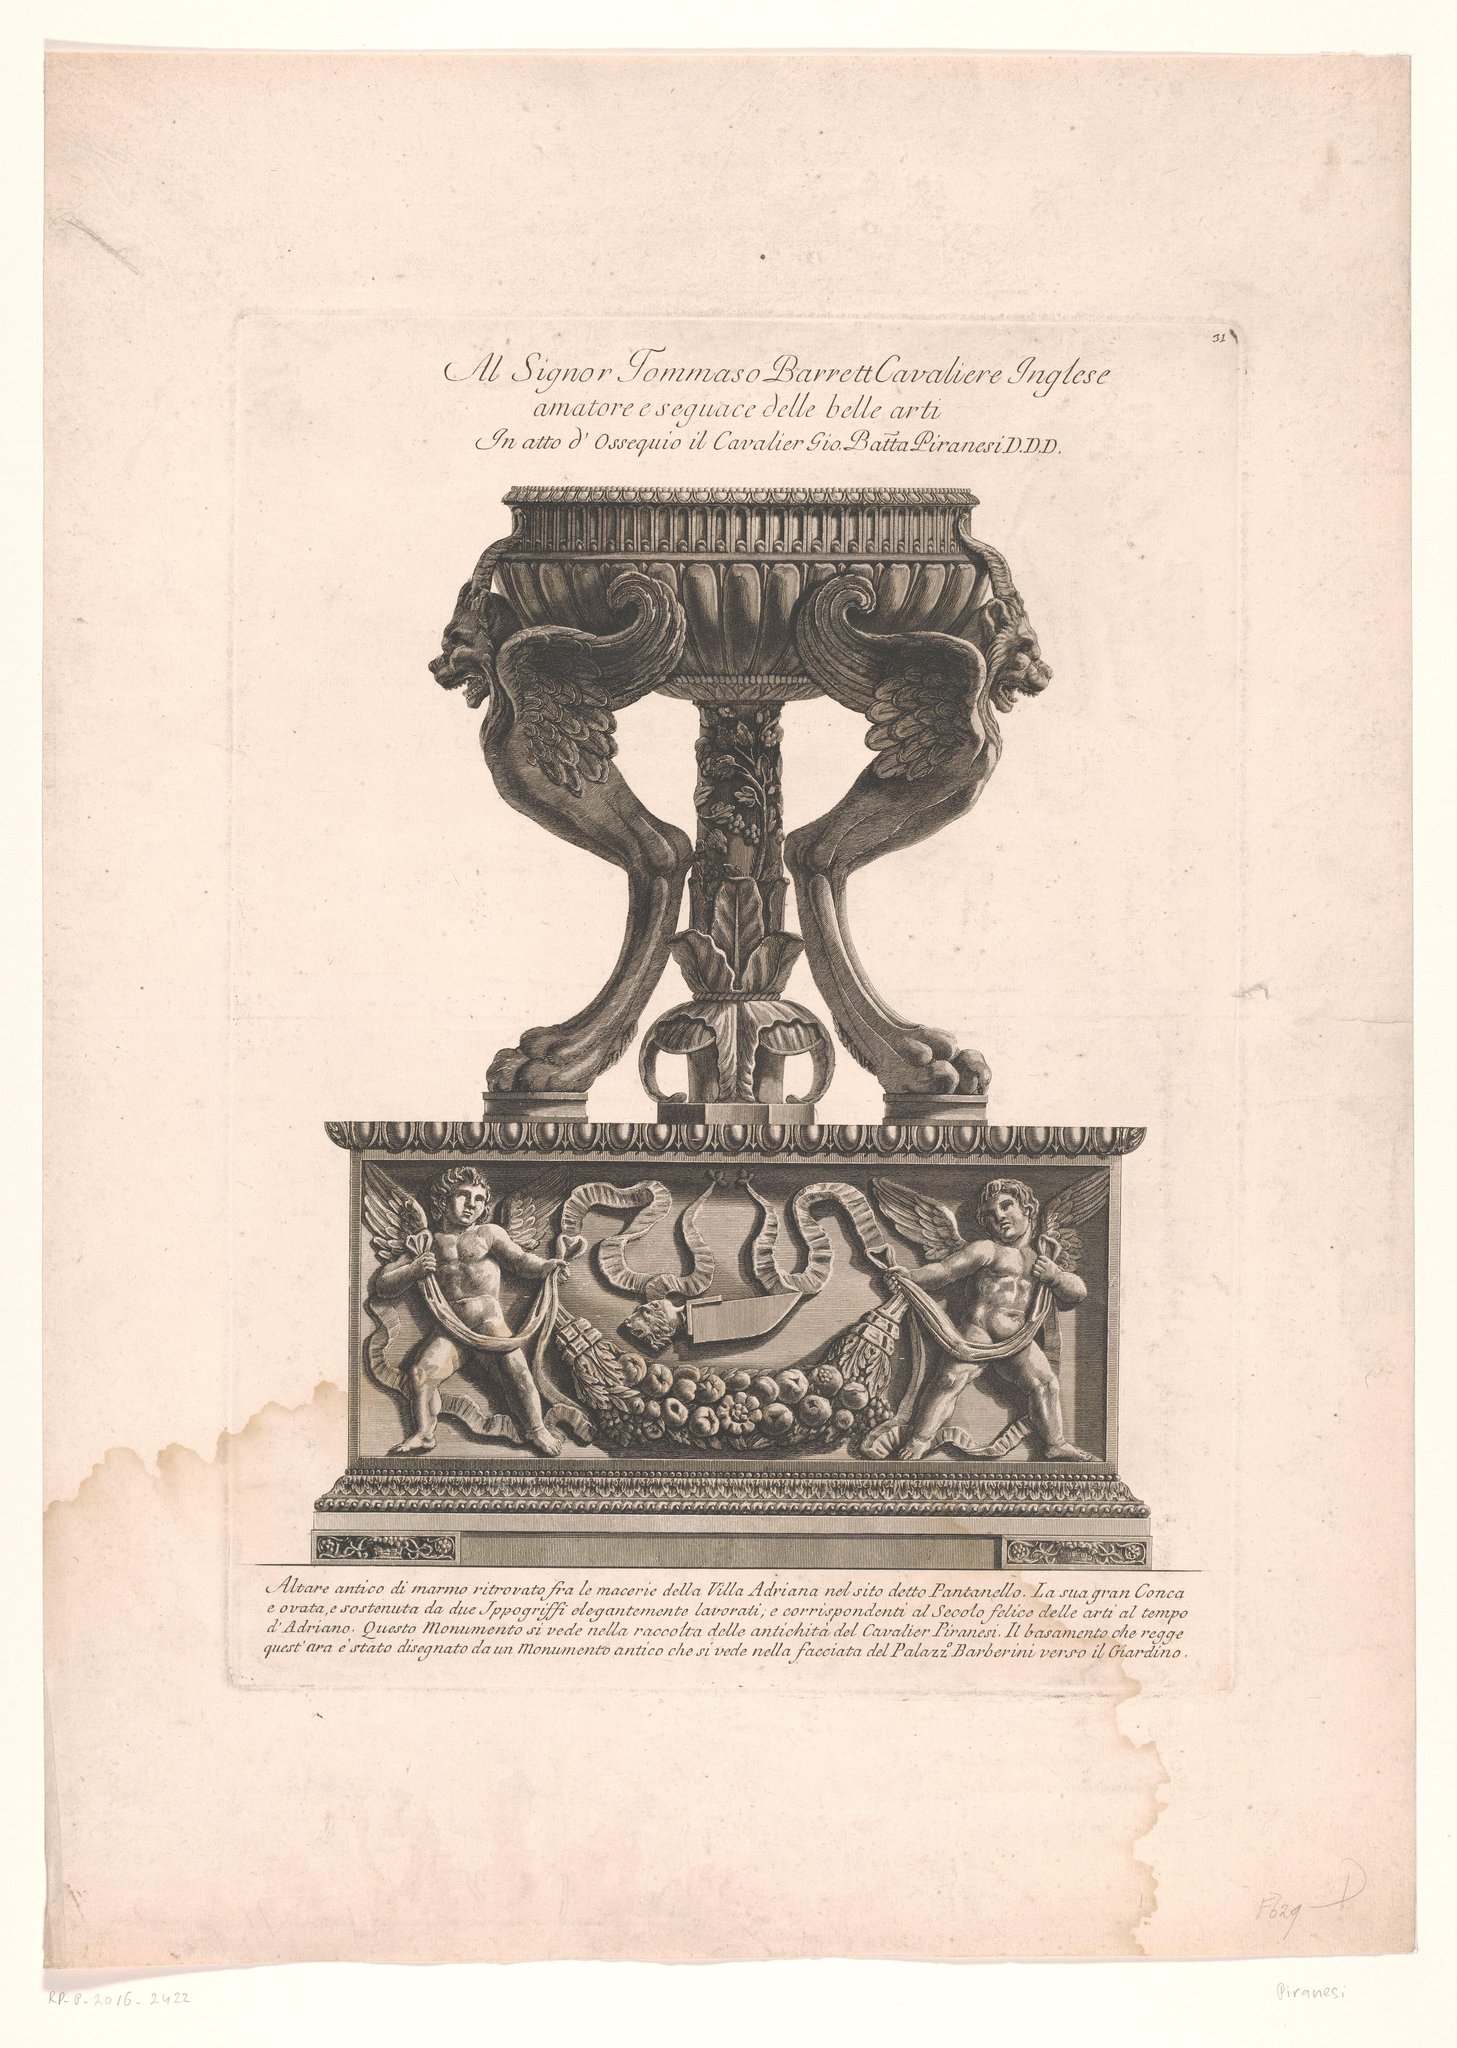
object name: print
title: Vasi, candelabri, cippi, sarcofagi, tripodi, lucerne, ed ornamenti antichi disegn. ed incisi dal cav. Gio. Batta Piranesi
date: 1778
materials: paper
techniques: etching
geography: rome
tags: altar ~ non-christian religions, altar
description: De 'Vasi'-reeks telt 110 prenten, verspreid over twee volumes met elk een eigen titelprent. Piranesi werd voor deze reeks geholpen door verschillende assistenten uit zijn werkplaats, waaronder zijn zoon Francesco die ook nog eens 8 platen toevoegde aan de reeks in 1779-1780.